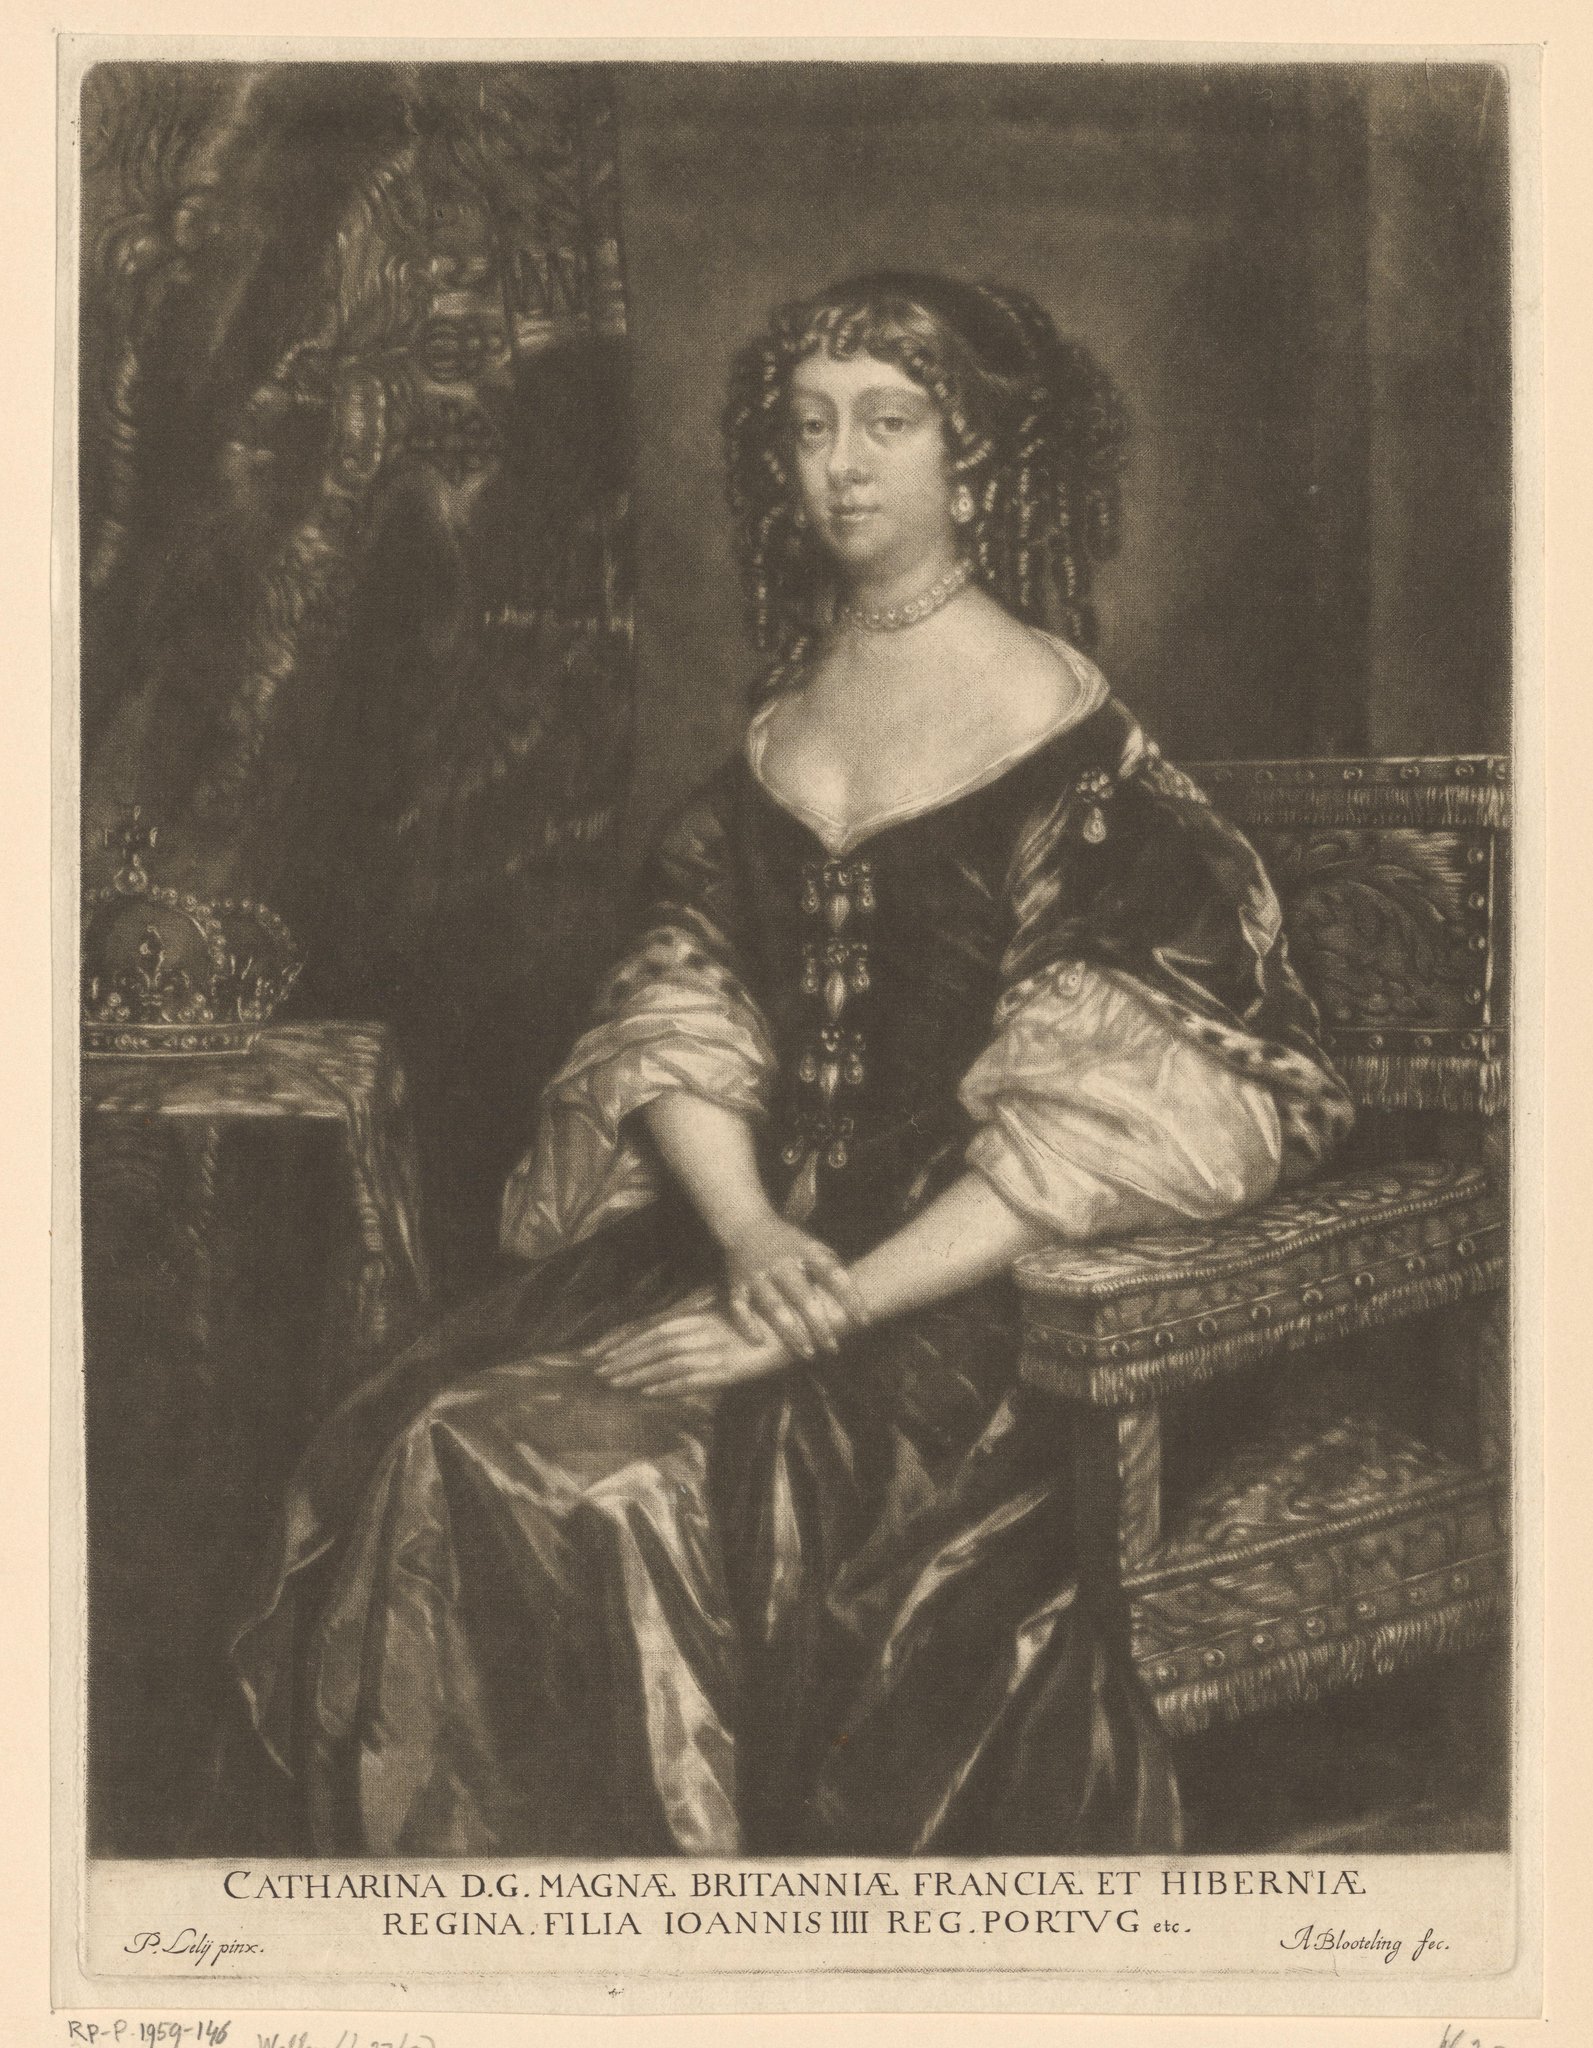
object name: print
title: Portret van Catharina van Bragança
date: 1662-1690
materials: paper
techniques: engraving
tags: catharina van bragança, crown (symbol of sovereignty), historical persons - bb - woman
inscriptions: collector's mark: Lugt 2760, collector's mark: ‘MP’, collector's mark: Lugt 2228